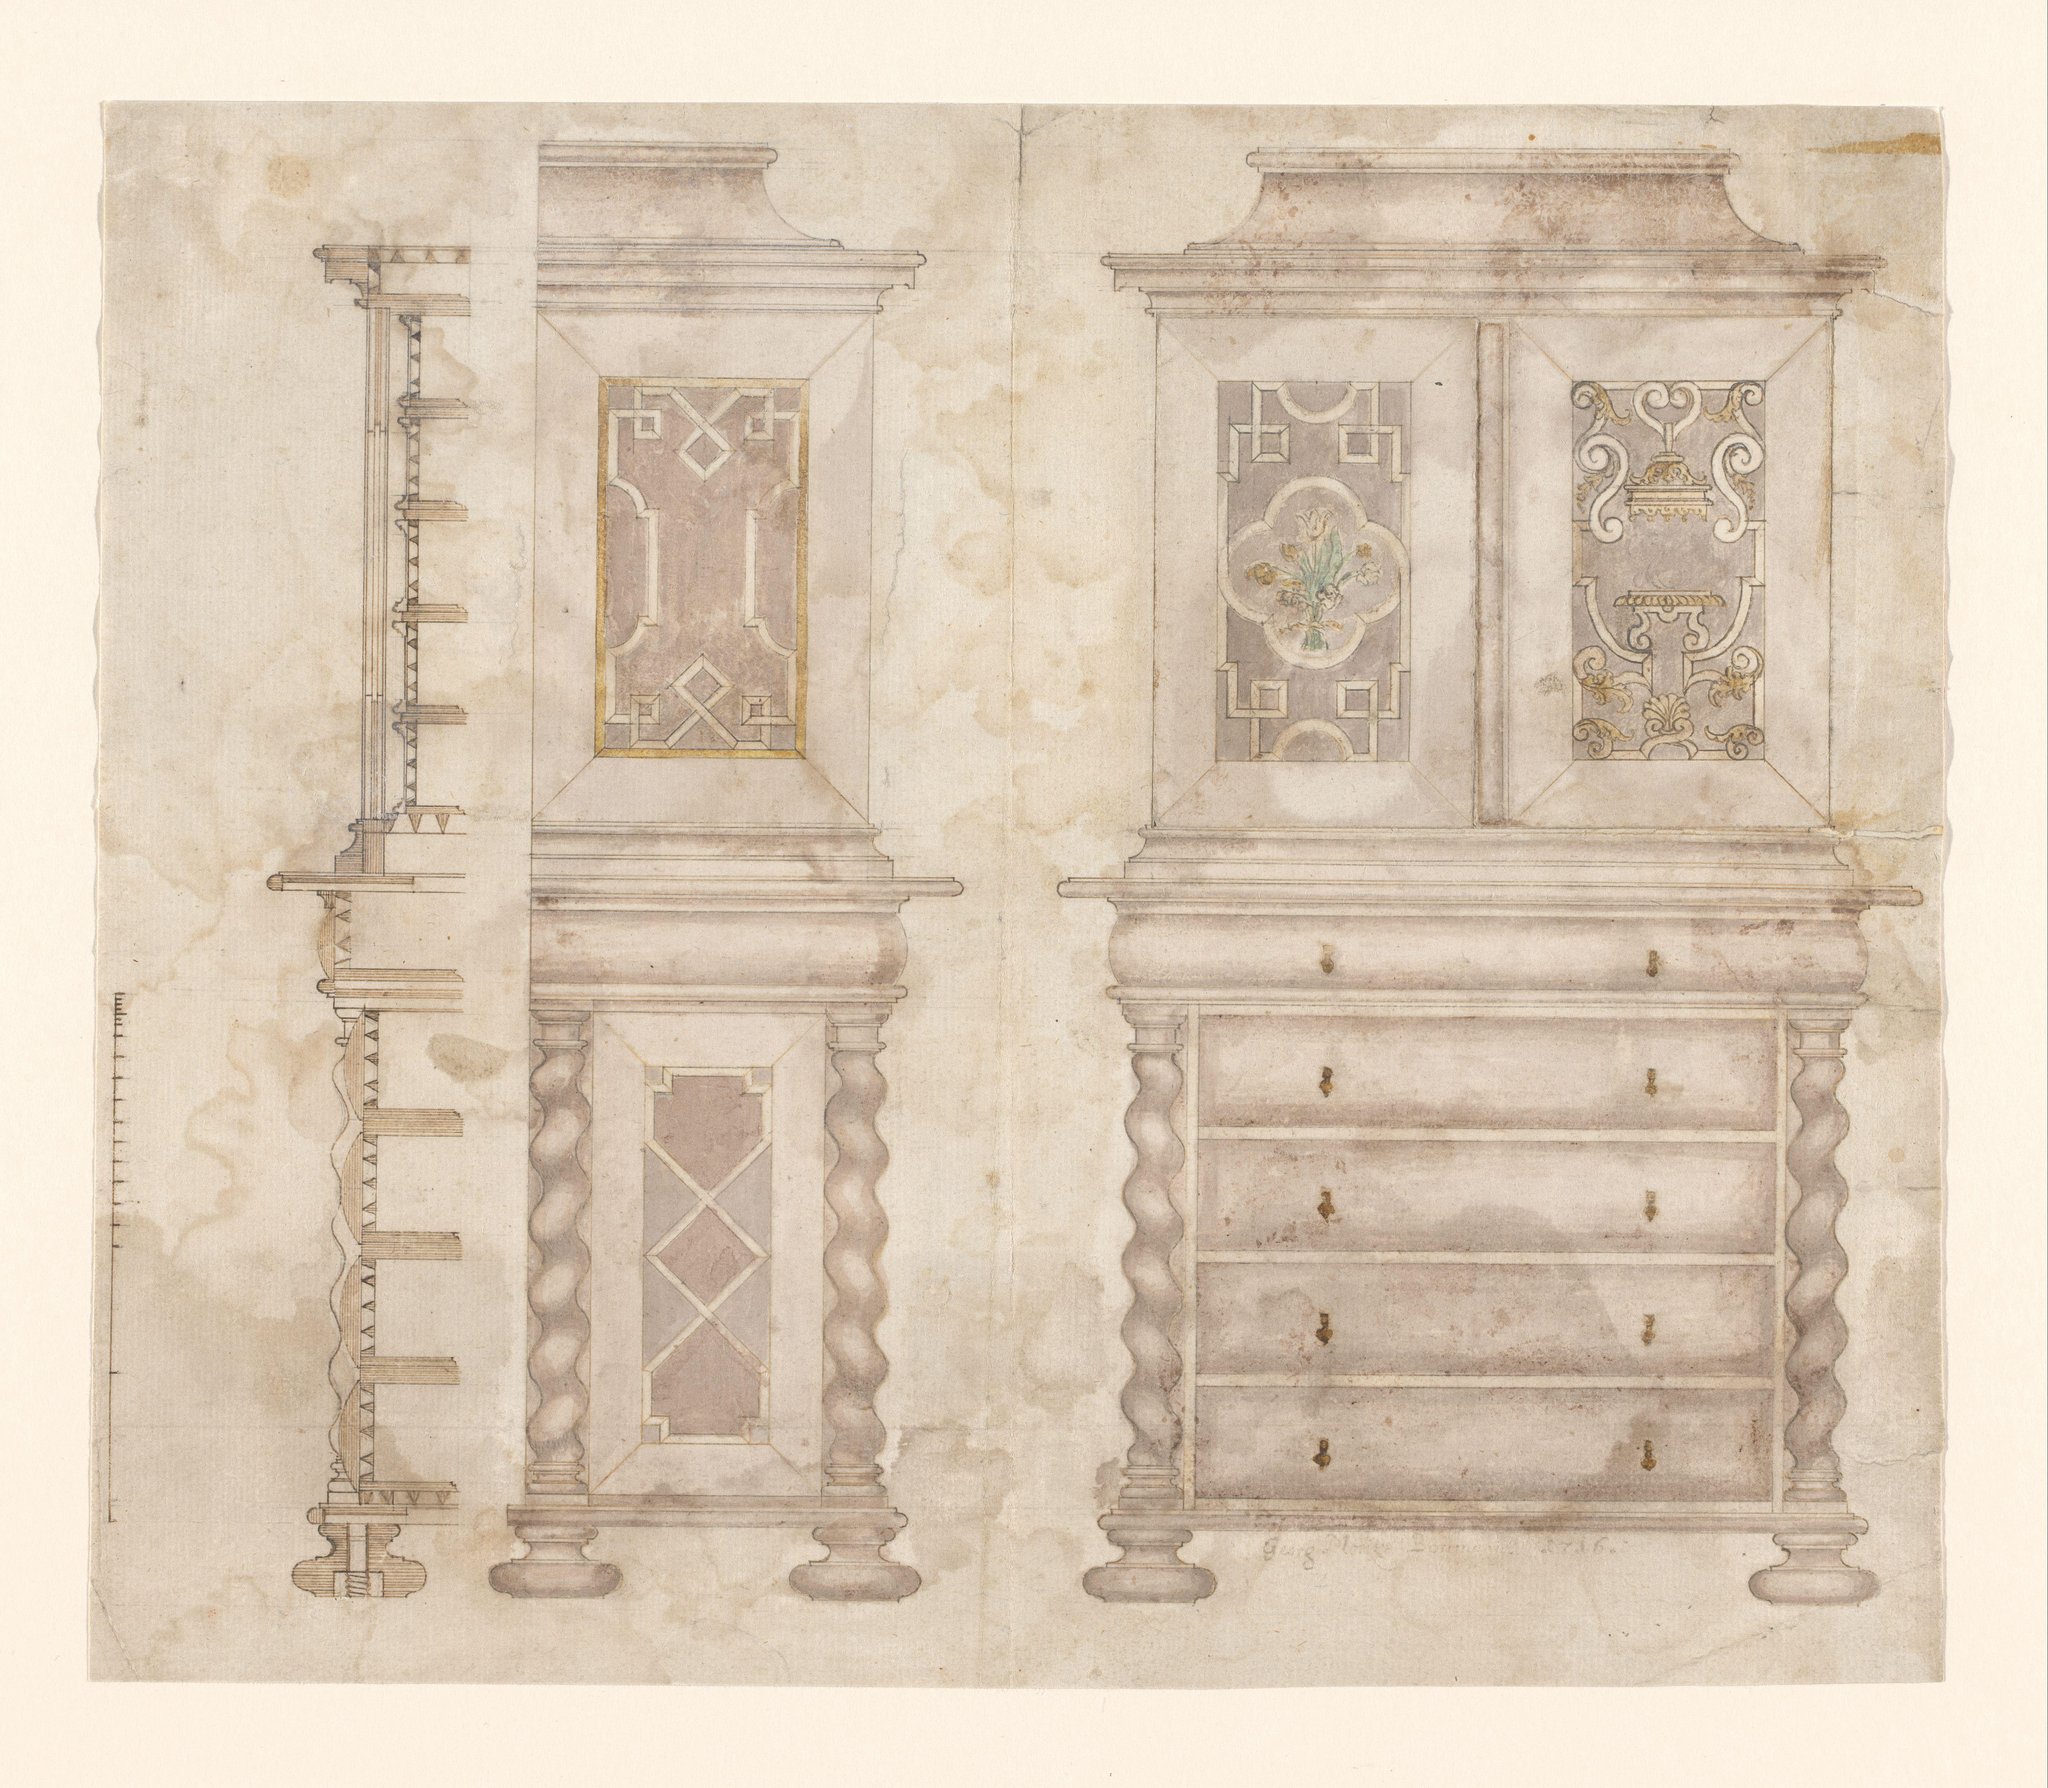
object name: drawing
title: Ontwerp voor een verzamelaarskabinet op een commodevormig onderstel, met papieren deurtjes in de bovenkast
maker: georg moritz borrmann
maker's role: draughtsman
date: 1716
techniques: drawing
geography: germany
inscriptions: signature and date: ‘Georg Moritz Borrmann 1716’, size: ‘maatverdeling’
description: De twee opgeplakte deurtjes kunnen geopend worden en hebben elk een andere decoratie.